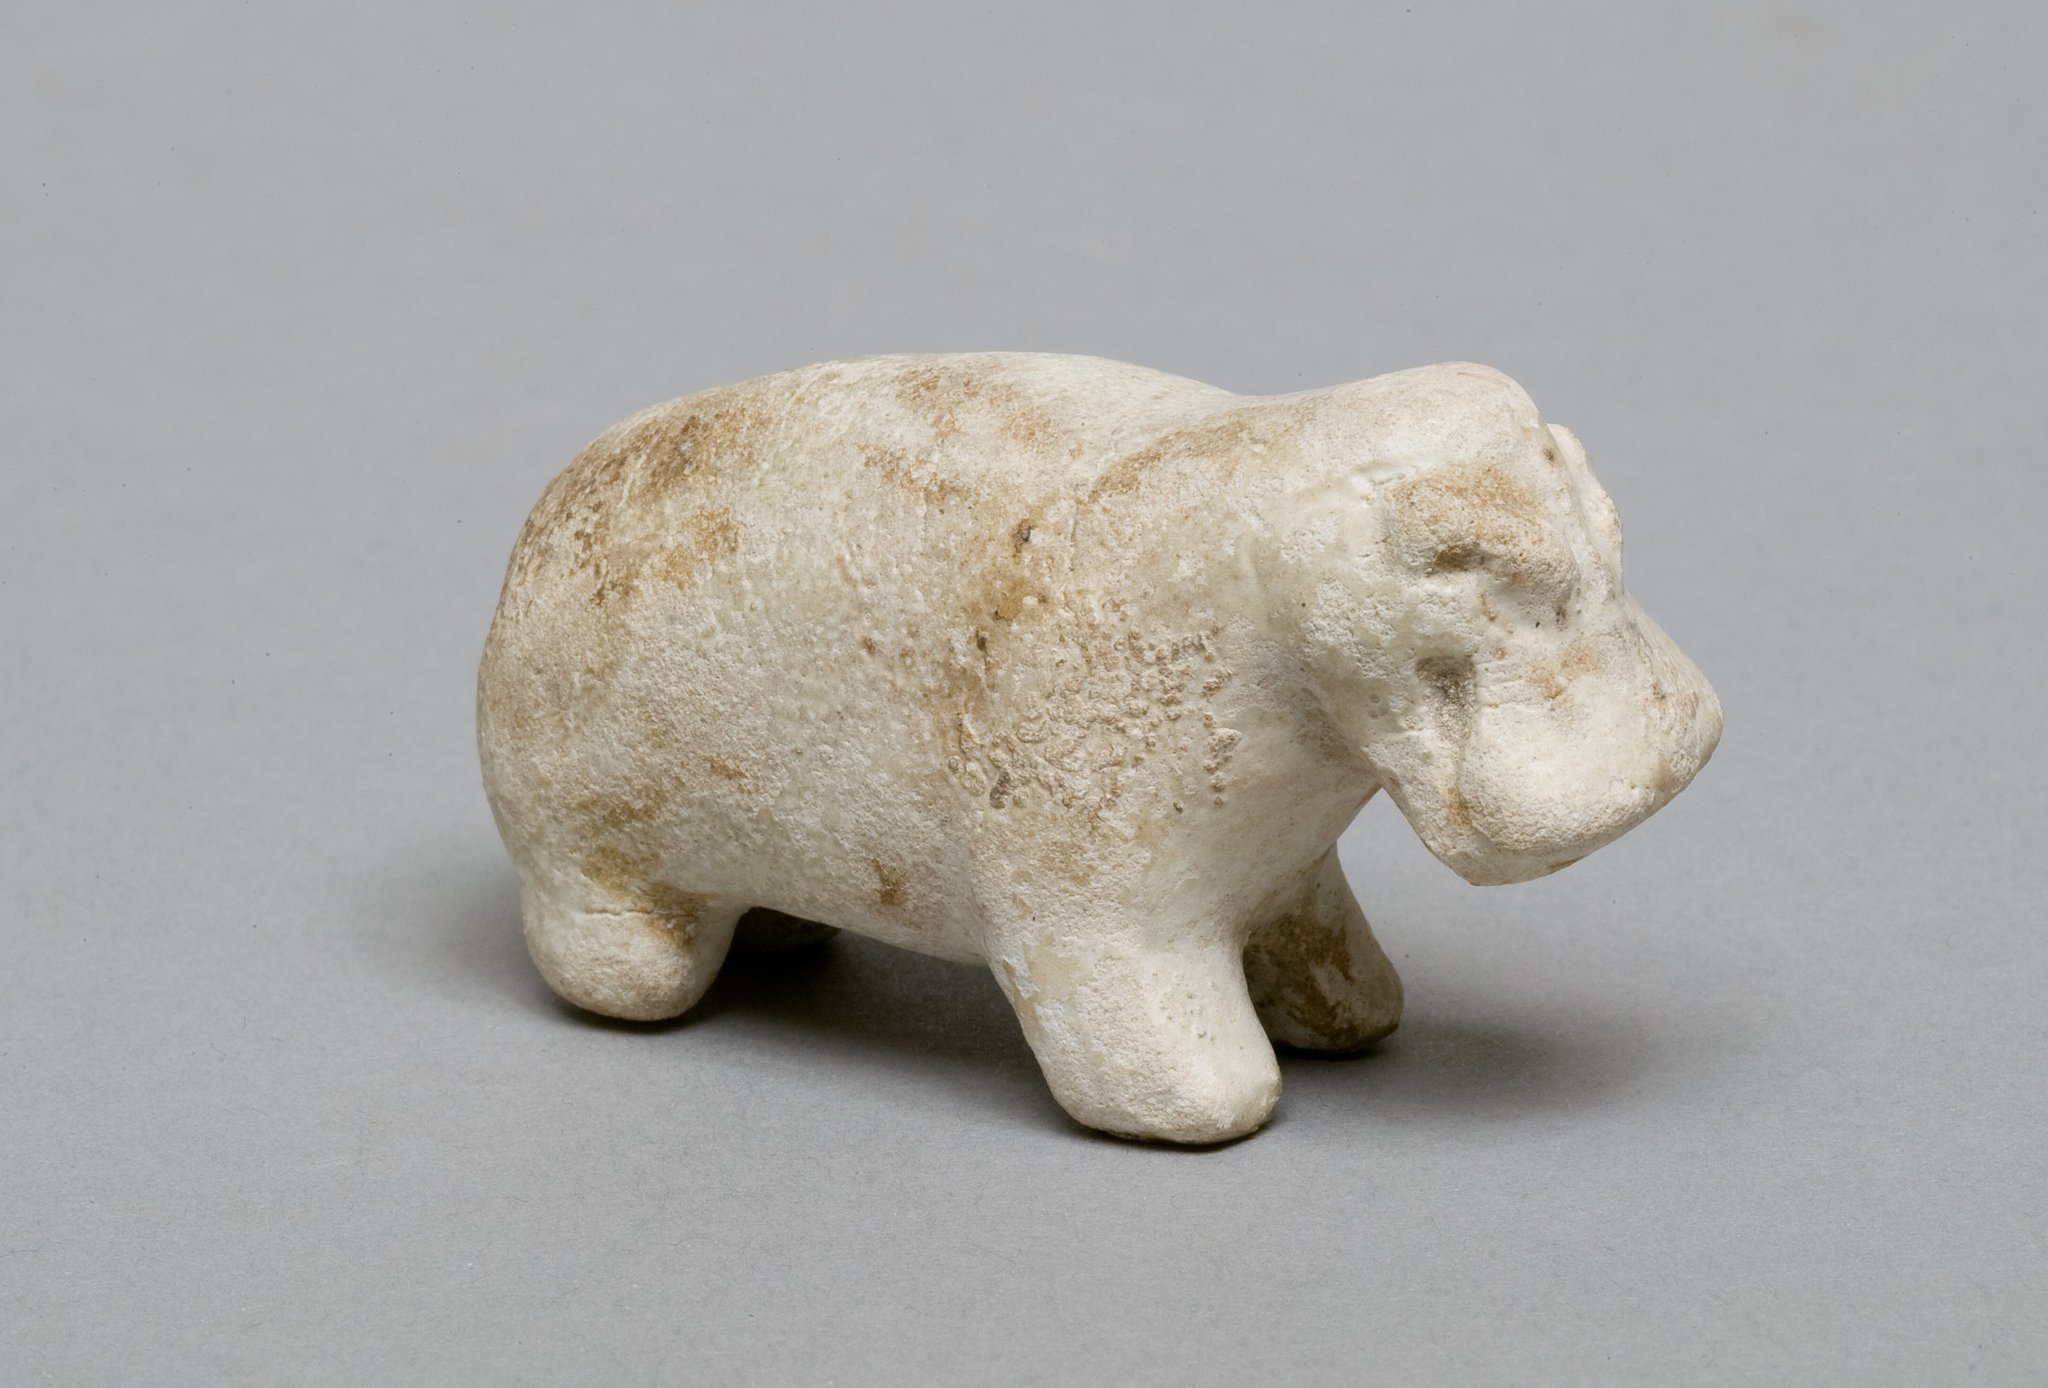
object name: figurine, hippopotamus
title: Hippopotamus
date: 1850-1775 BCE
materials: faience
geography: egypt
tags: hippos